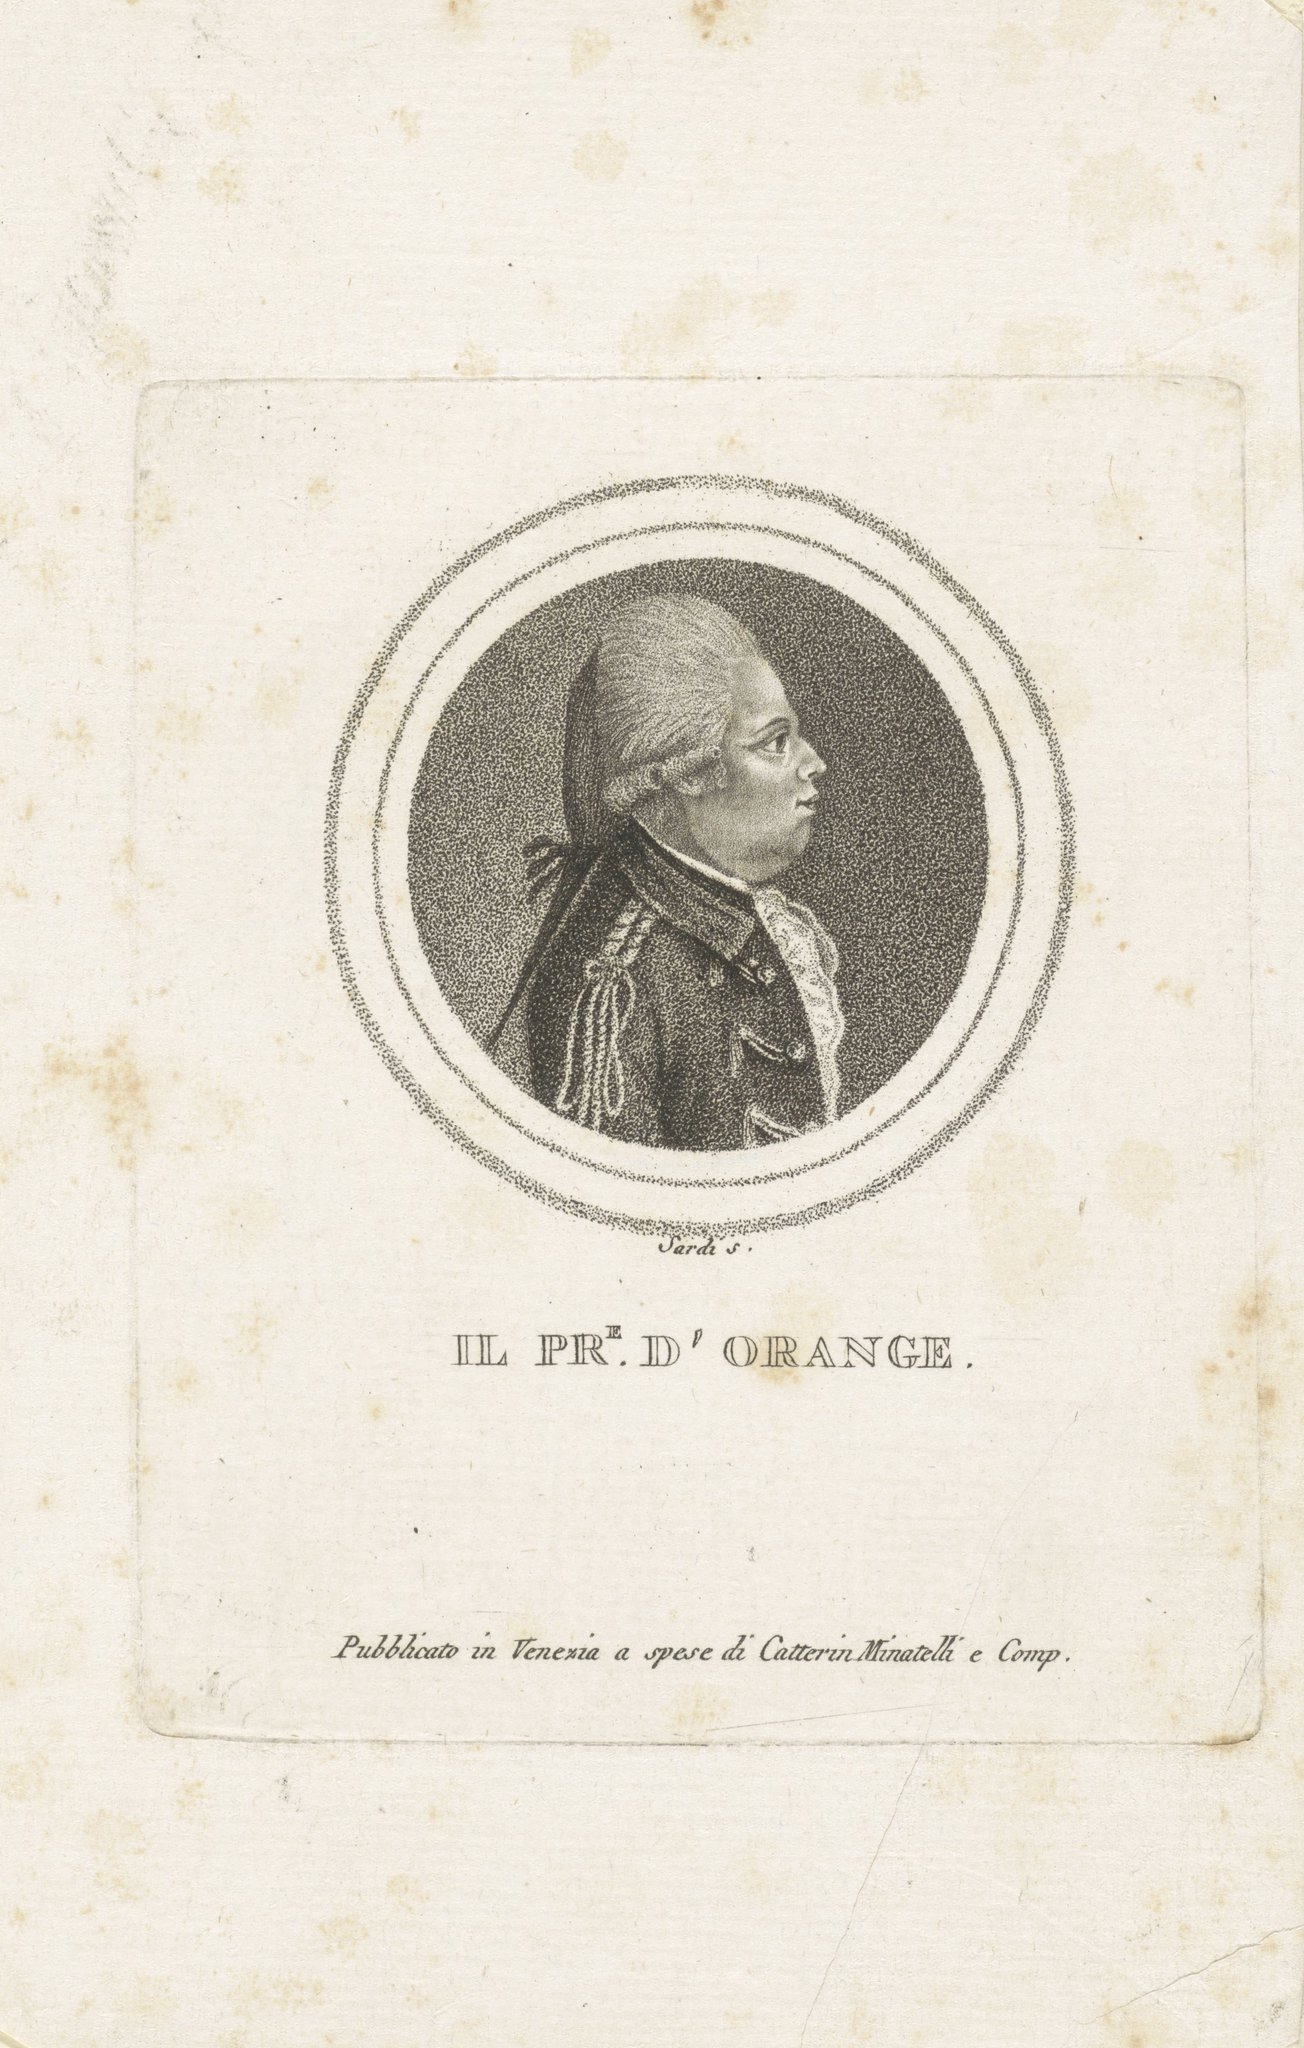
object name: print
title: Portret van Willem V, prins van Oranje-Nassau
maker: sardi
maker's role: print maker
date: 1775-1849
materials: paper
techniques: engraving, etching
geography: italy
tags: the hague, william v (prince of orange)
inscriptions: collector's mark: Lugt 2228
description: De hier vermelde titel verwijst naar de hoogst verkregen titel van de geportretteerde, niet per se naar de titel die de geportretteerde op deze voorstelling draagt.